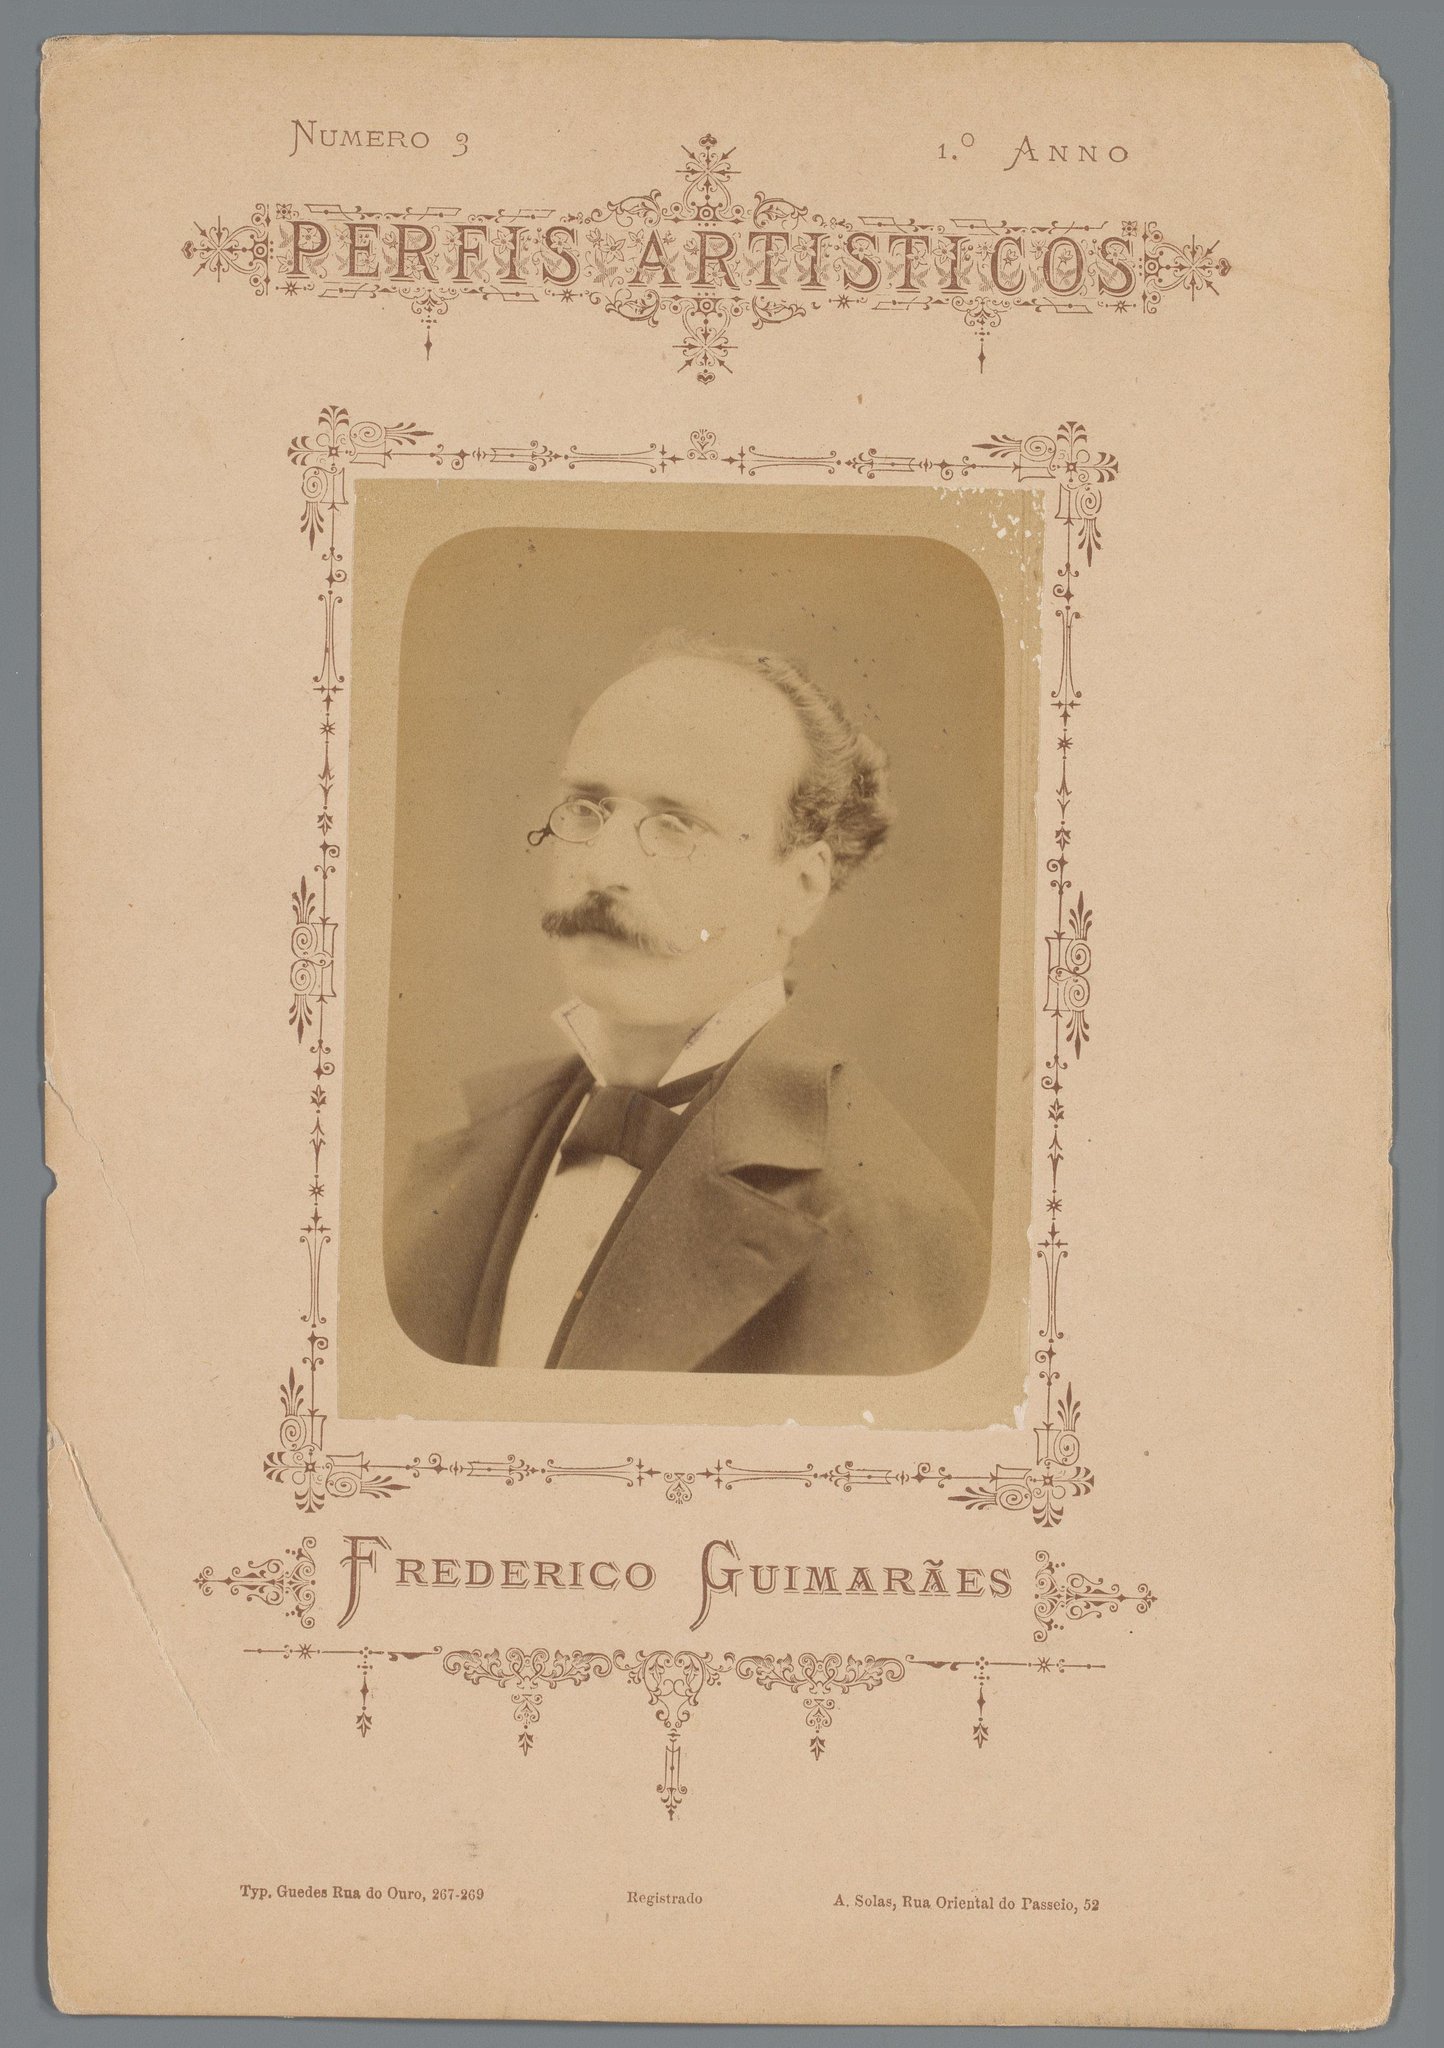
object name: photograph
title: Frederico Guimarães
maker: alexandre solas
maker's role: fotograaf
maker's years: 1870-1902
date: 1880-1890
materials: cardboard, paper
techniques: albumen print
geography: lisbon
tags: historical persons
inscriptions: inscription: ‘Typ. Guedes, R. do Ouro, 267-269 Registrado A. Solas, Rua Oriental do Passeio, 52’, number: ‘NUMERO 3 1.0 ANNO’